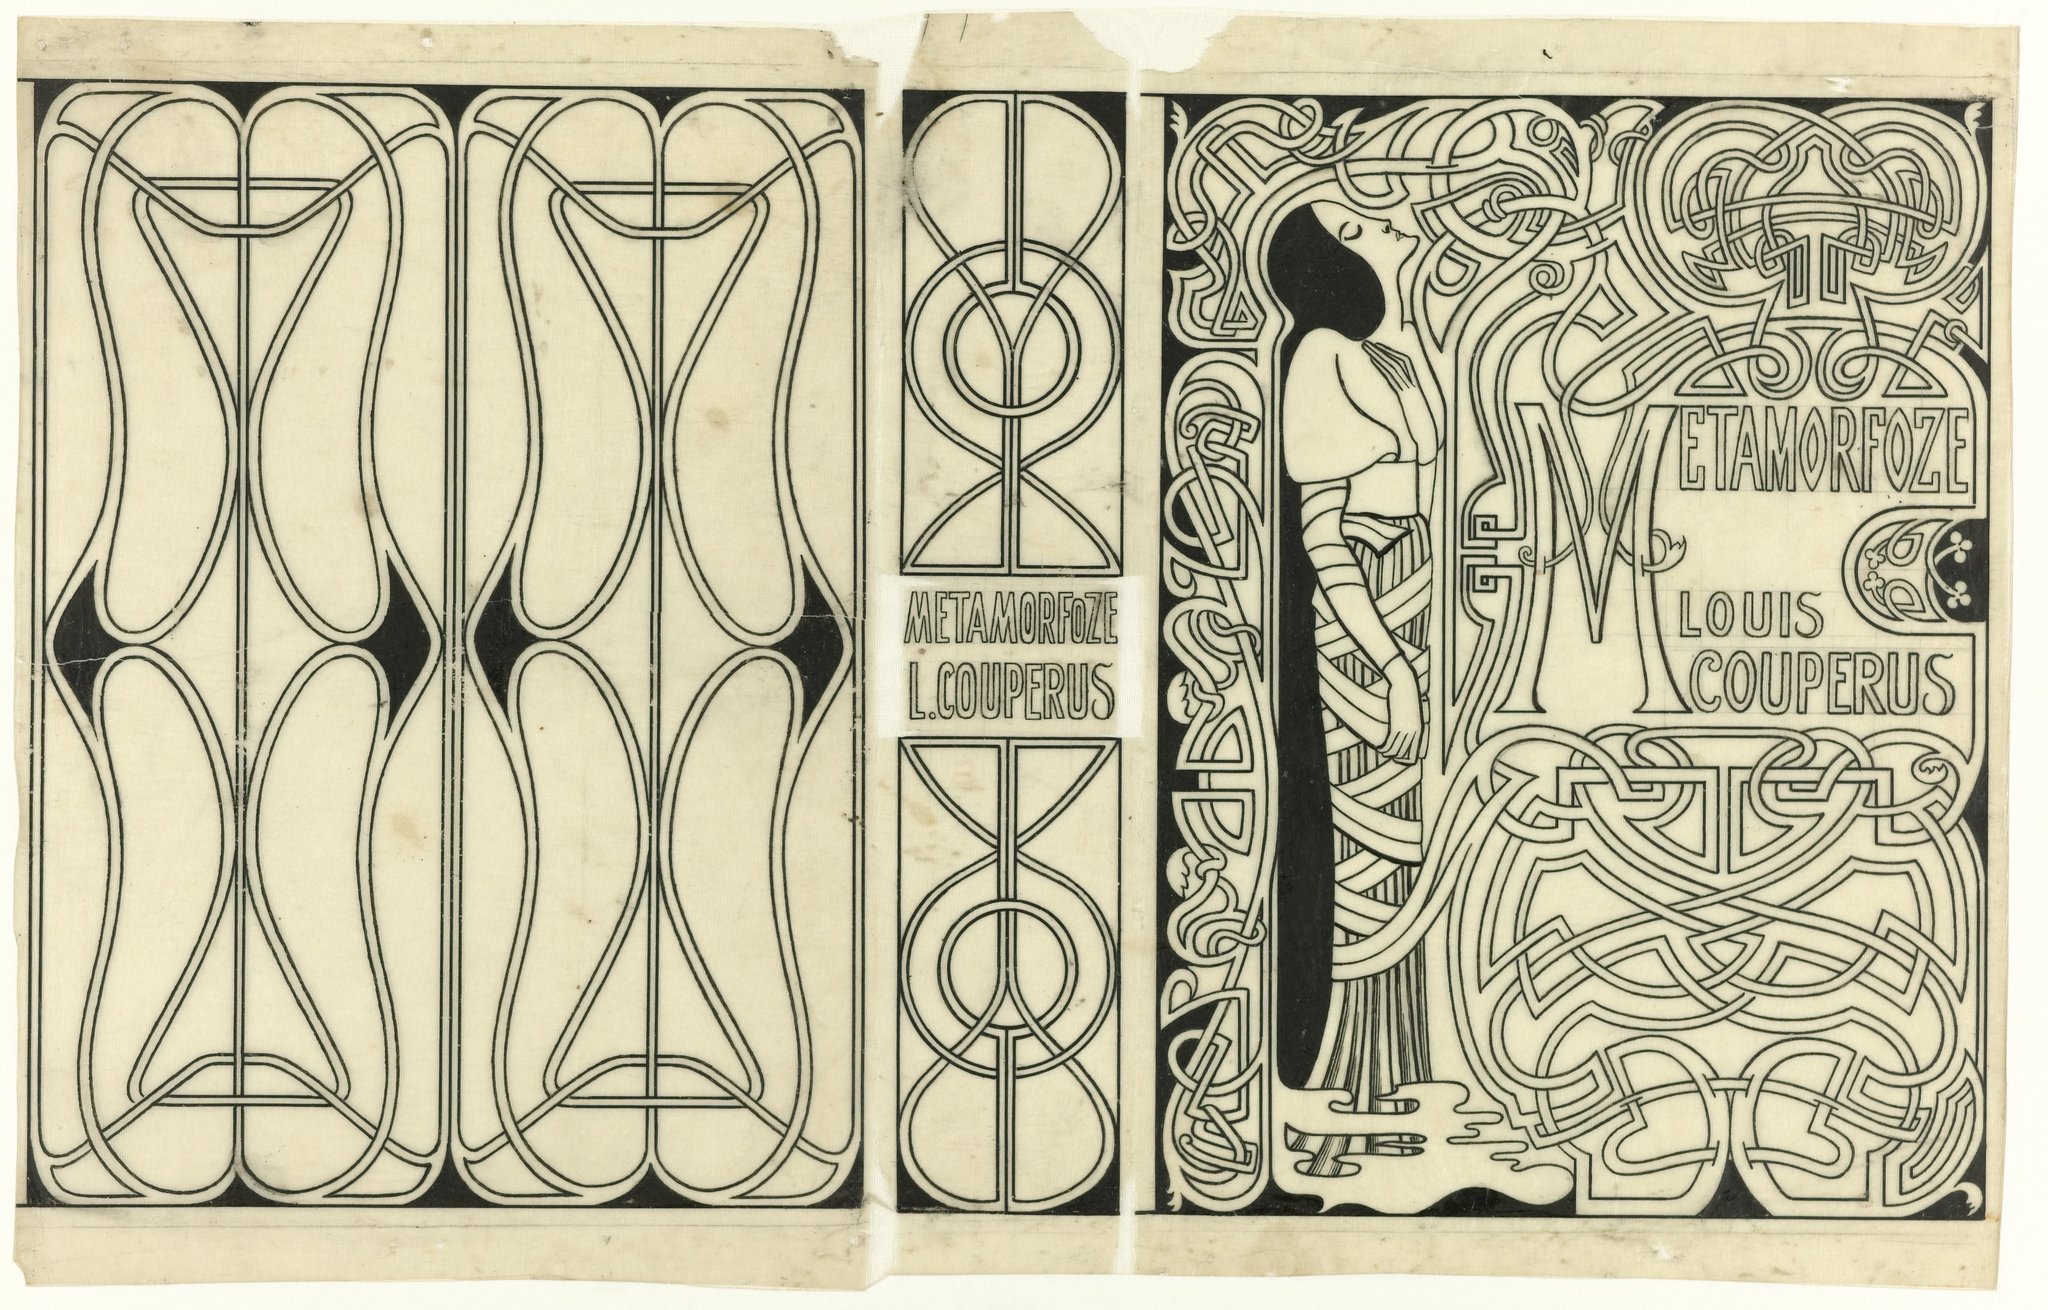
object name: study for binding design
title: Bandontwerp voor: Louis Couperus, Metamorfoze, 1897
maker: jan toorop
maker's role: draughtsman, painter, print maker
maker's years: 1858-1928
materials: ink, pencil, paper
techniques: brush, pen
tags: interlace ~ ornament, eyes closed, standing figure - aa - female human figure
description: Boektitel en auteursnaam in een web van elkaar overlappende lijnen. Links een vrouw met haren tot aan de grond die haar hoofd omhoog wendt. Haar ogen zijn gesloten en haar linkerhand rust op haar borst.